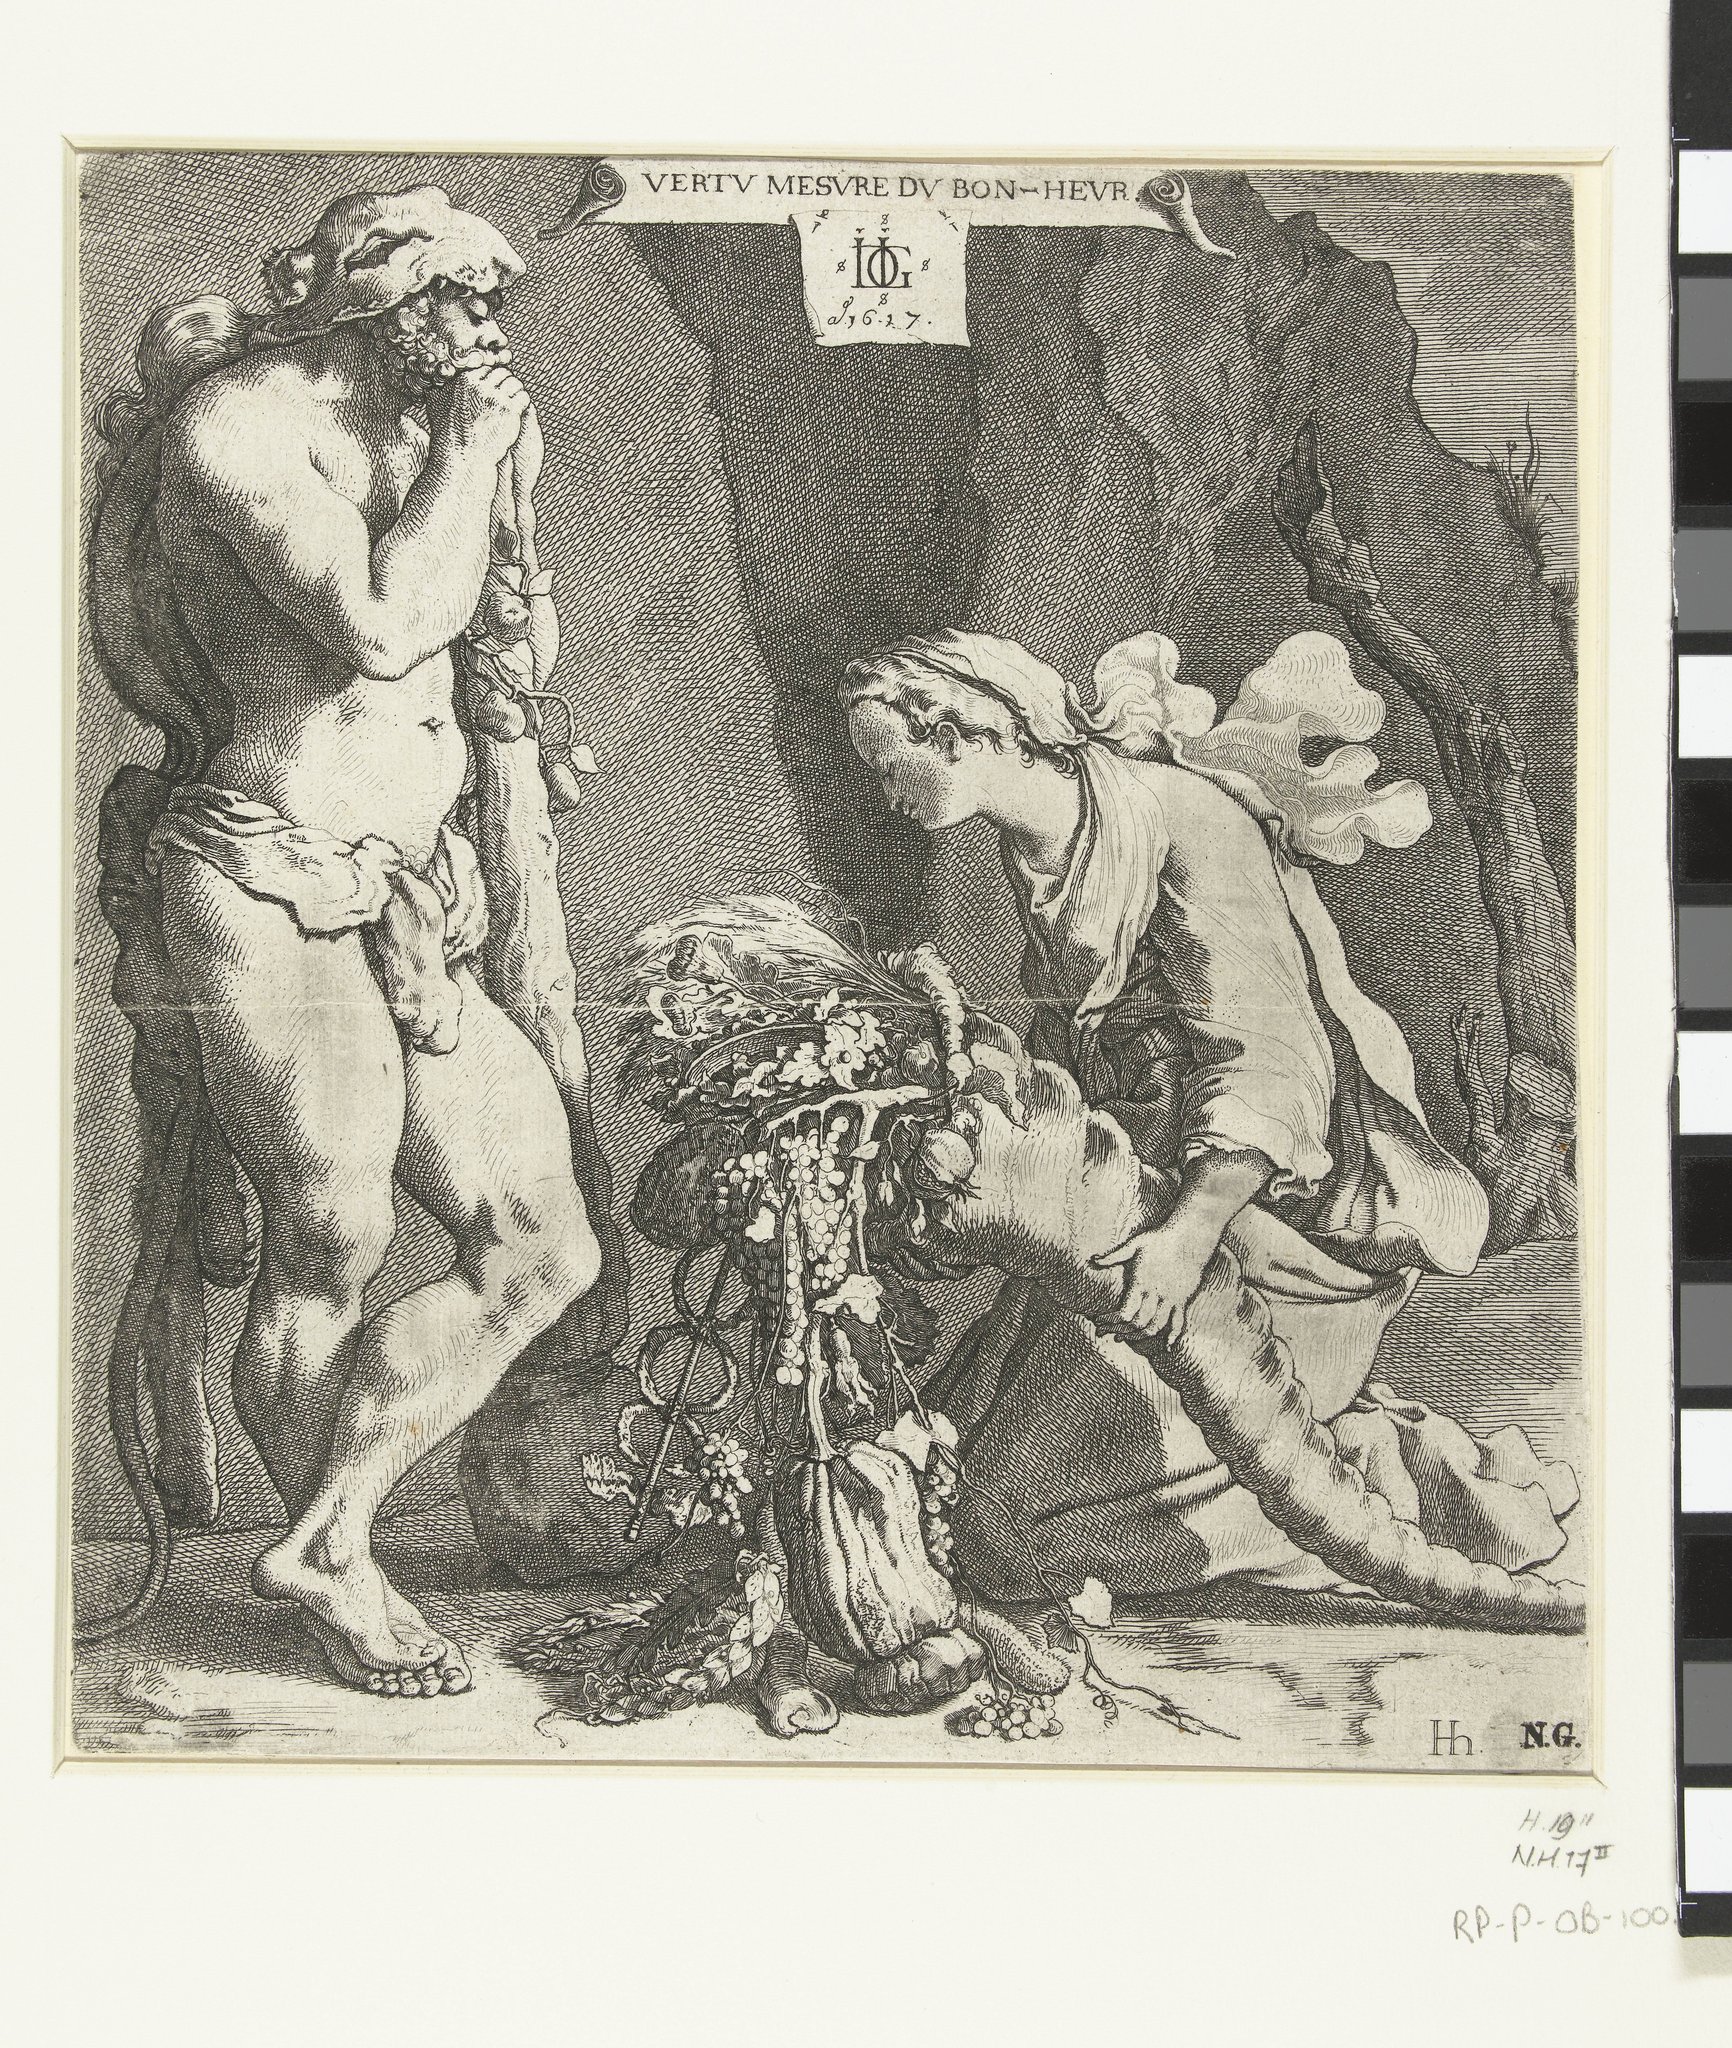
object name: print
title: Fortuna biedt de hoorn des overvloeds aan Hercules aan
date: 1617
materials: paper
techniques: etching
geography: the hague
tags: (story of) hercules (heracles), 'cornucopia', horn of plenty, fortuna as roman personification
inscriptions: collector's mark: Lugt 1967, collector's mark: Lugt 2228a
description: Vrouwe Fortuna knielt in een bergachtige omgeving met de hoorn des overvloeds in de handen voor Hercules, die leunt op zijn knots.